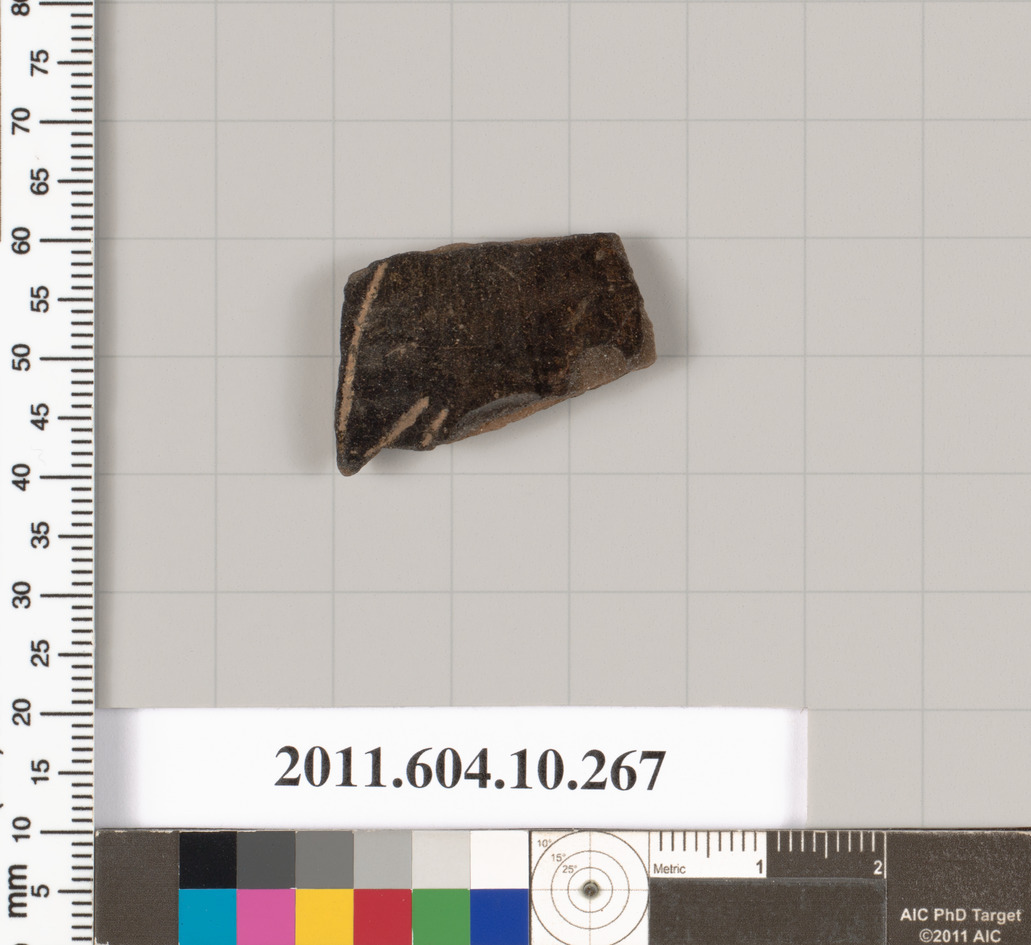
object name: undetermined shape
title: Terracotta fragment of an undetermined shape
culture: etruscan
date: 601-700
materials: terracotta